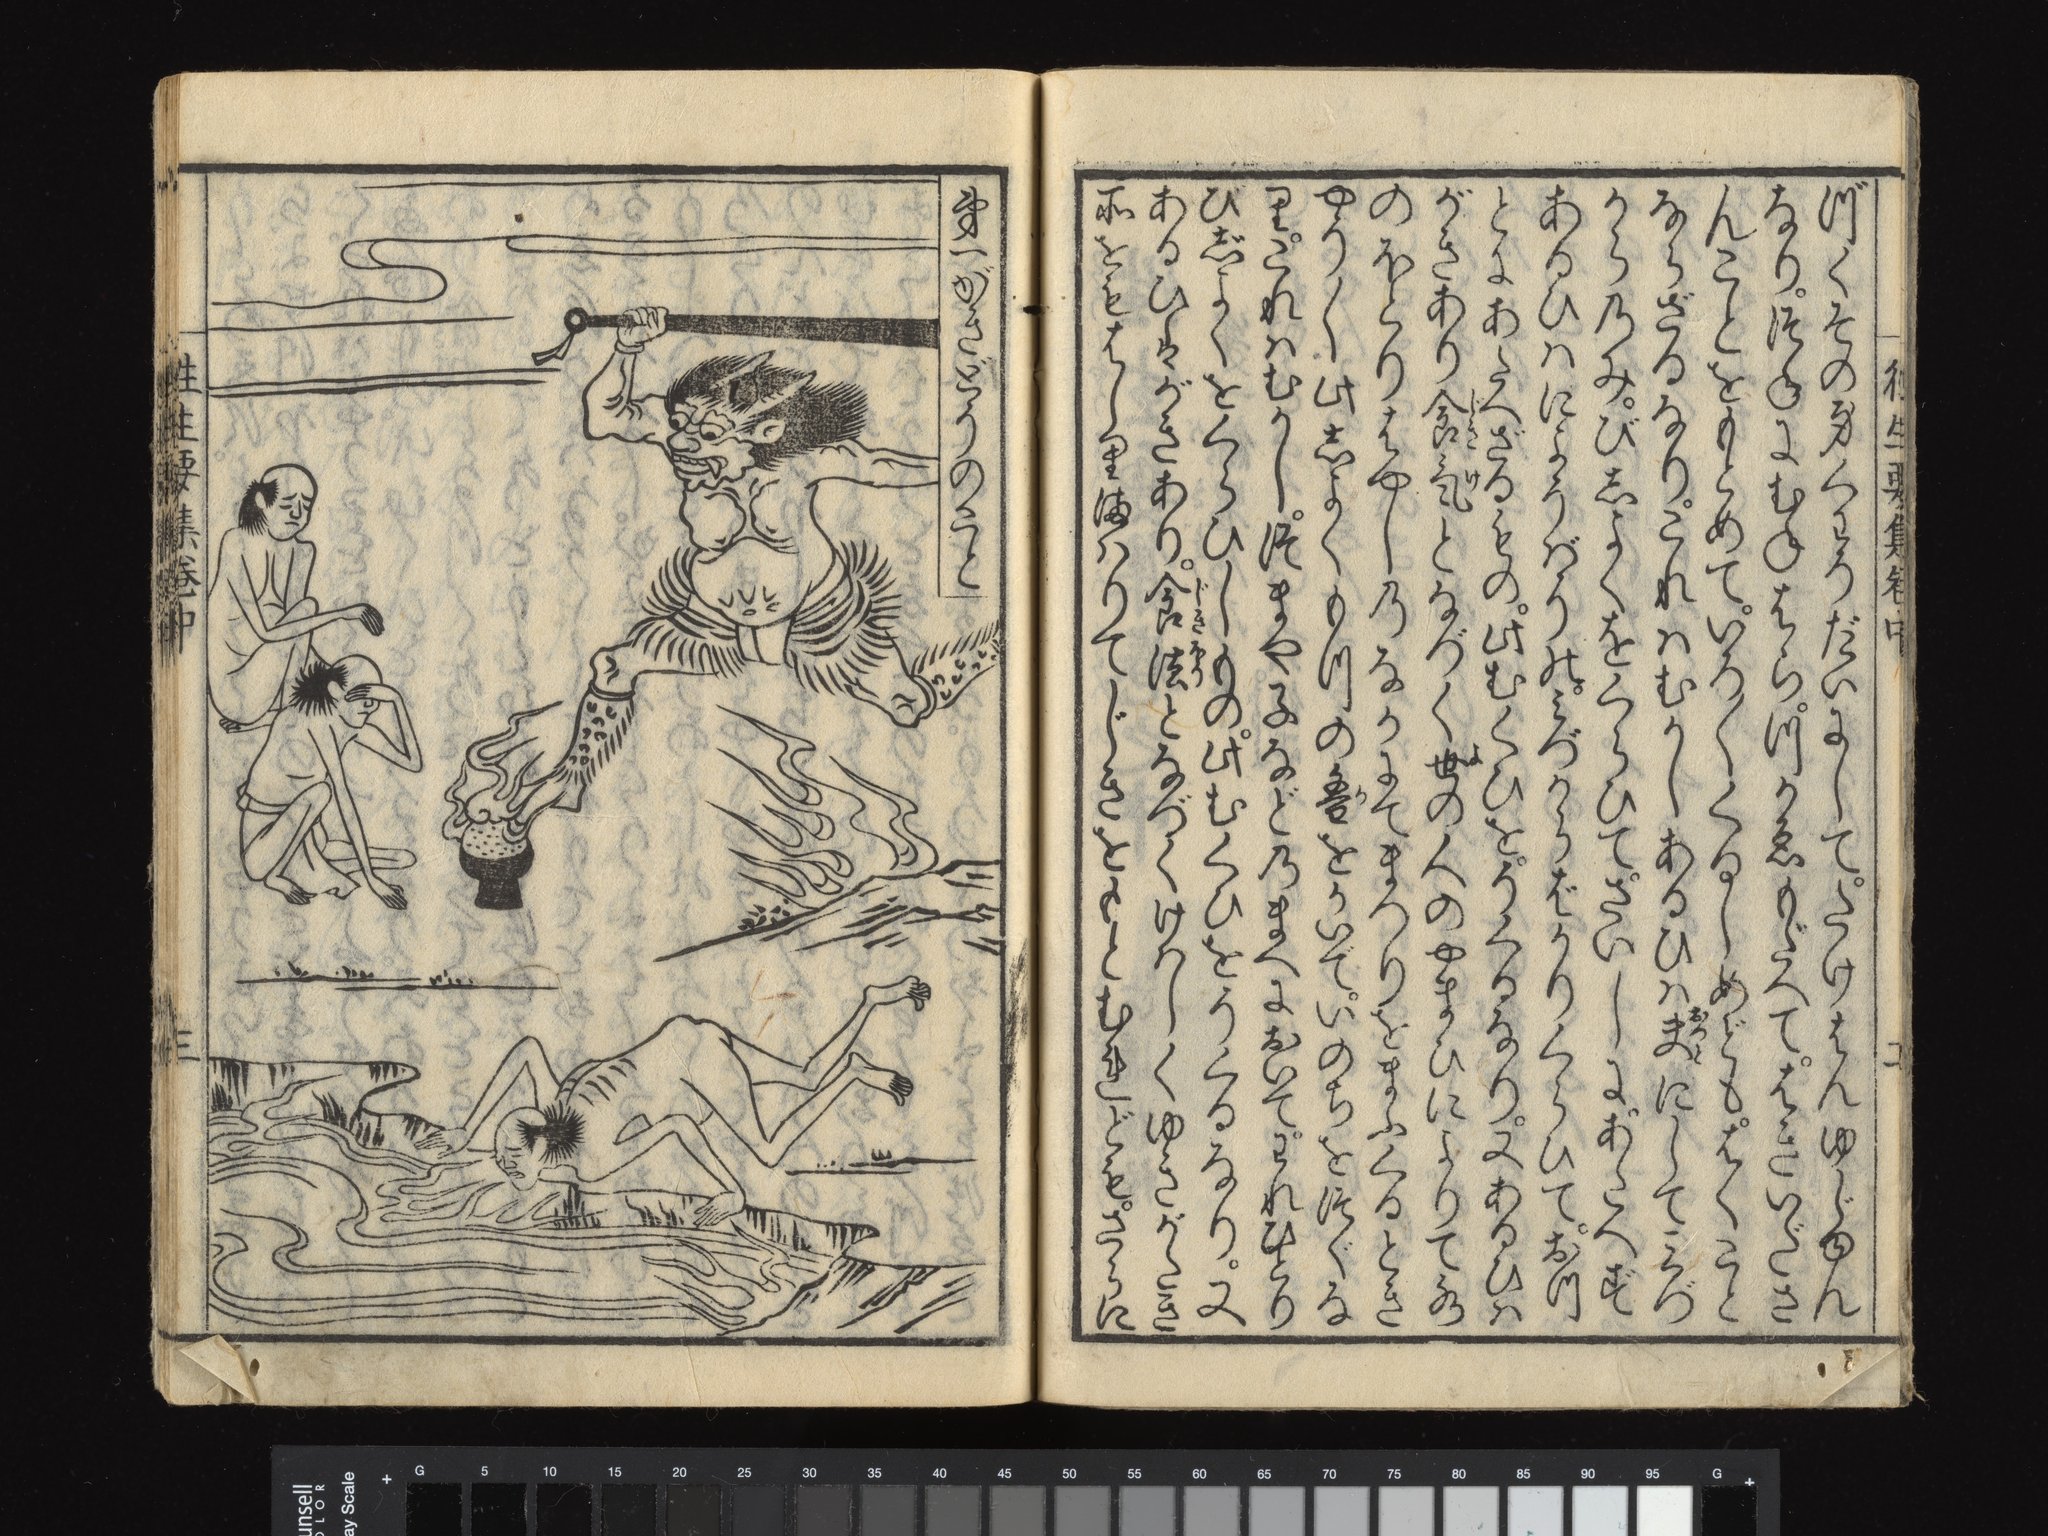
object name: illustrated book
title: The Essentials of Rebirth in the Pure Land (Ojōyōshū)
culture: japanese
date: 1790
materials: ink, paper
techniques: woodblock print